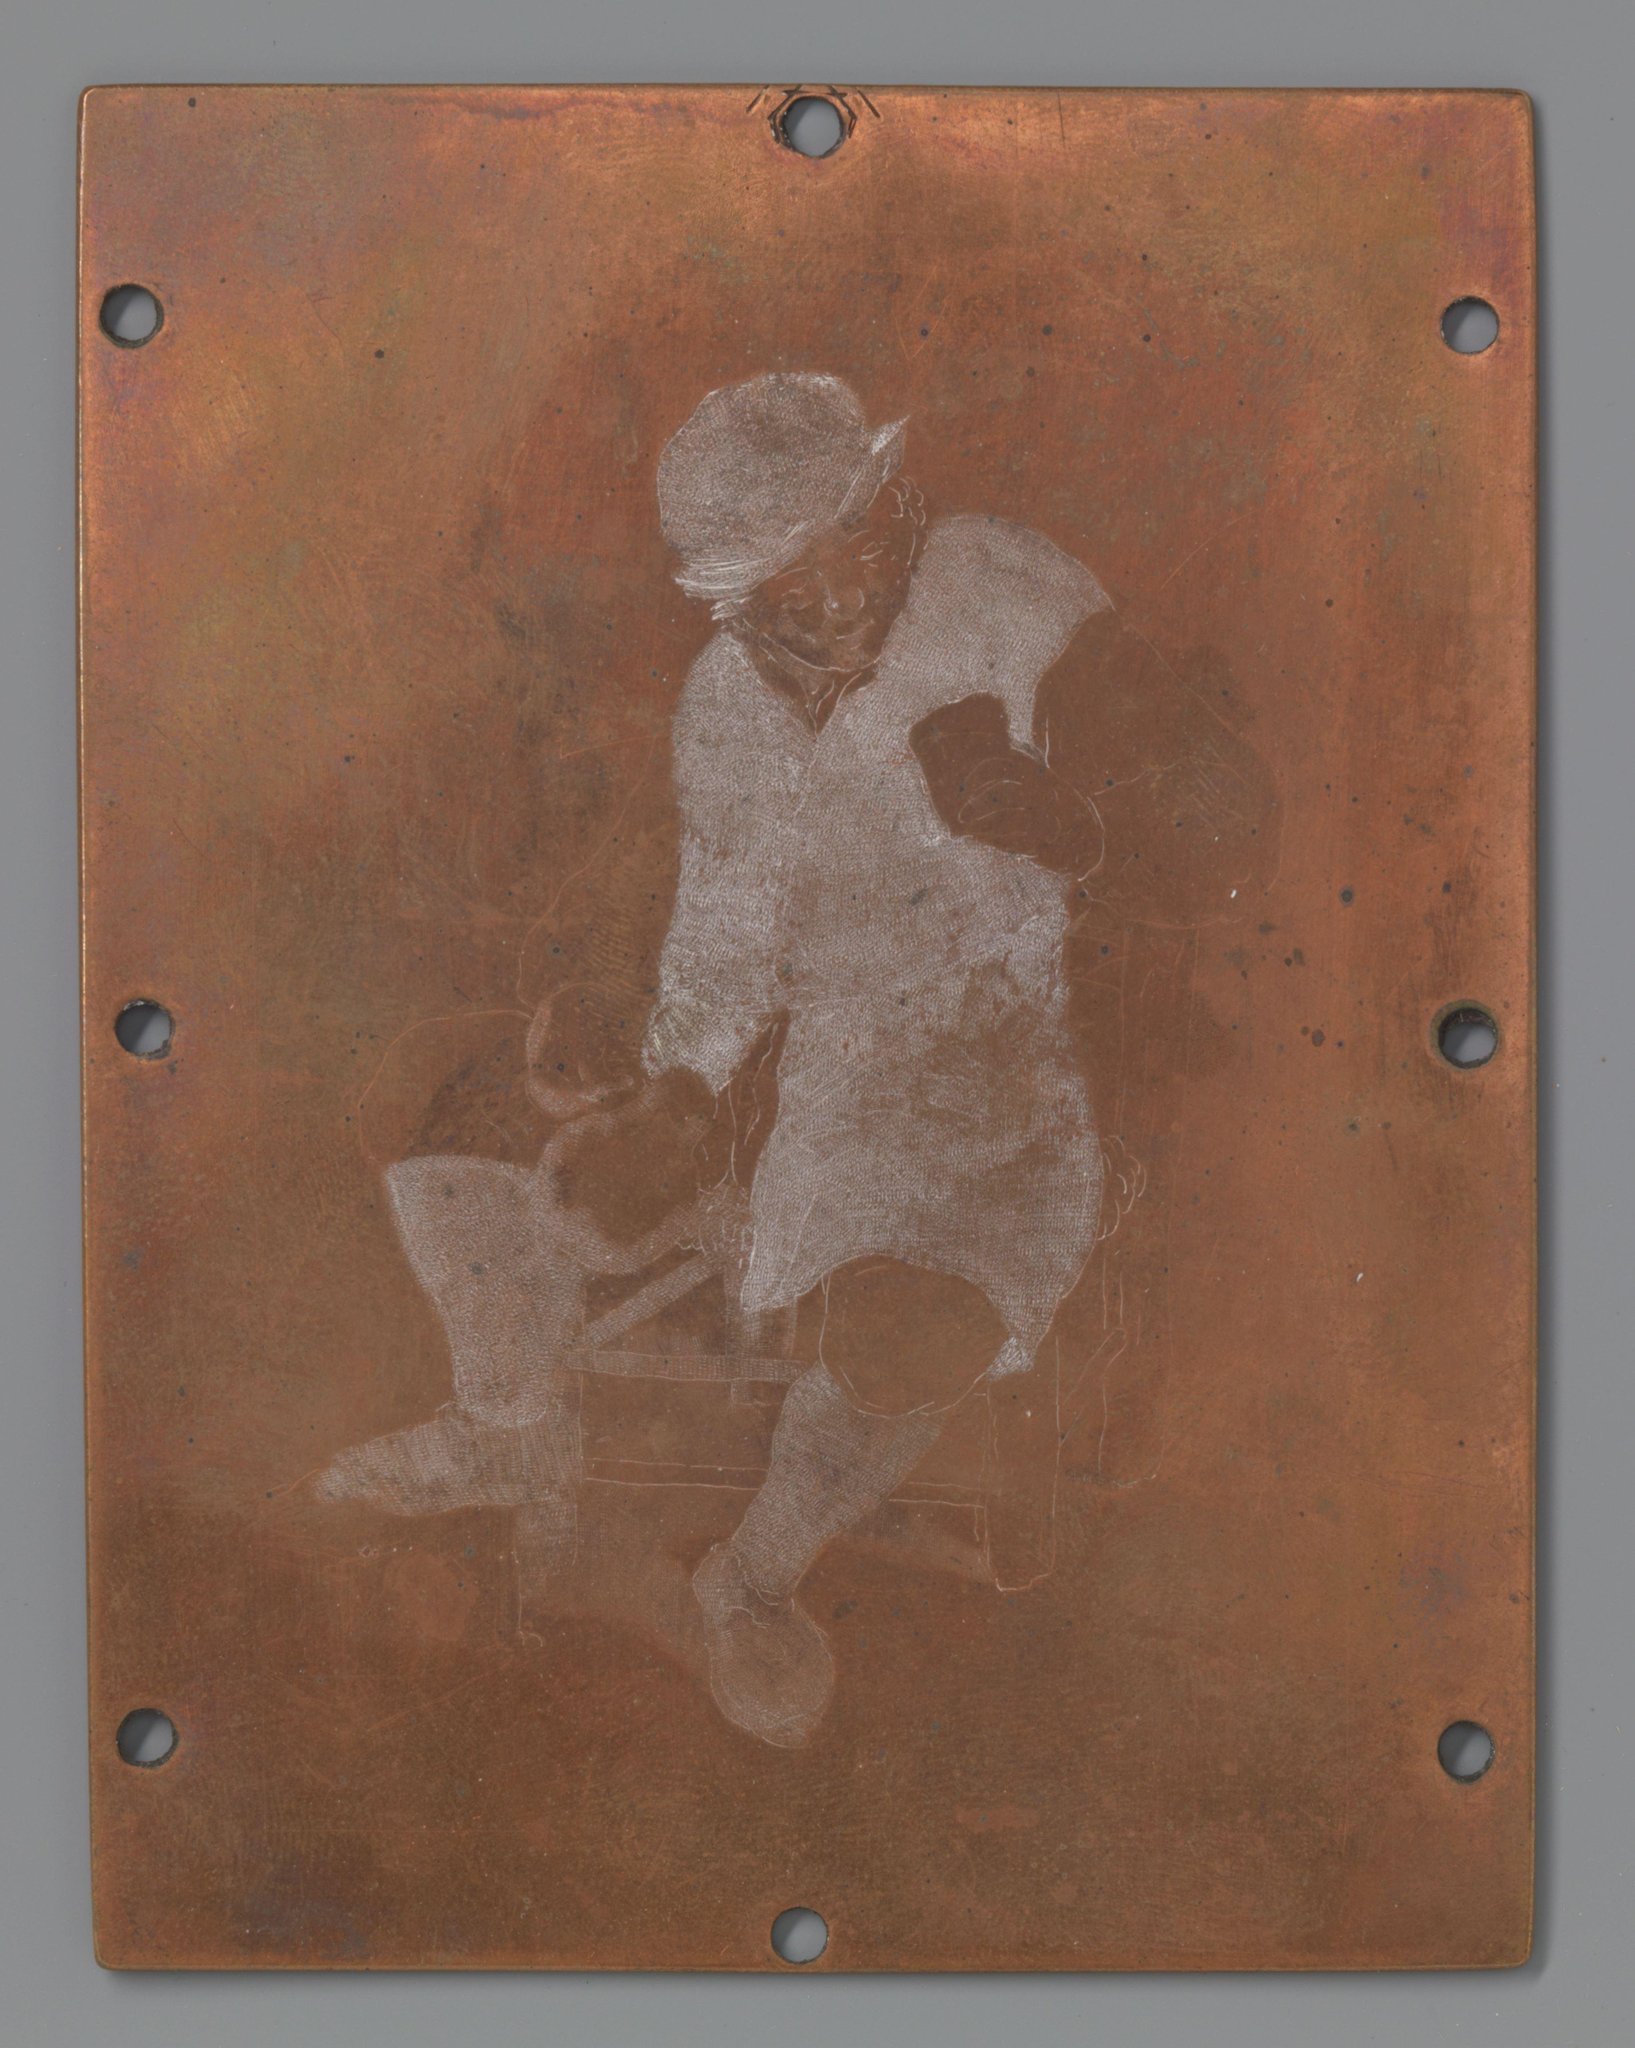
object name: copper plate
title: Zittende boer met kruik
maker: cornelis ploos van amstel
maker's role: draughtsman, print maker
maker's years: 1726-1798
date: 1763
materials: copper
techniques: etching, roulette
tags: sitting figure, jar, jug (used as drinking-vessel), farmers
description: Voor de prenttekening 'Zittende boer met kruik' maakte Ploos van Amstel vier verschillende platen (A, B, C, en D). Dit is plaat C. Er bestaan afdrukken van één, twee, drie of alle vier de platen in alle mogelijke combinaties. Voor afdrukken van alleen deze plaat, zie RP-P-1893-A-17957 en RP-P-1893-A-17943.